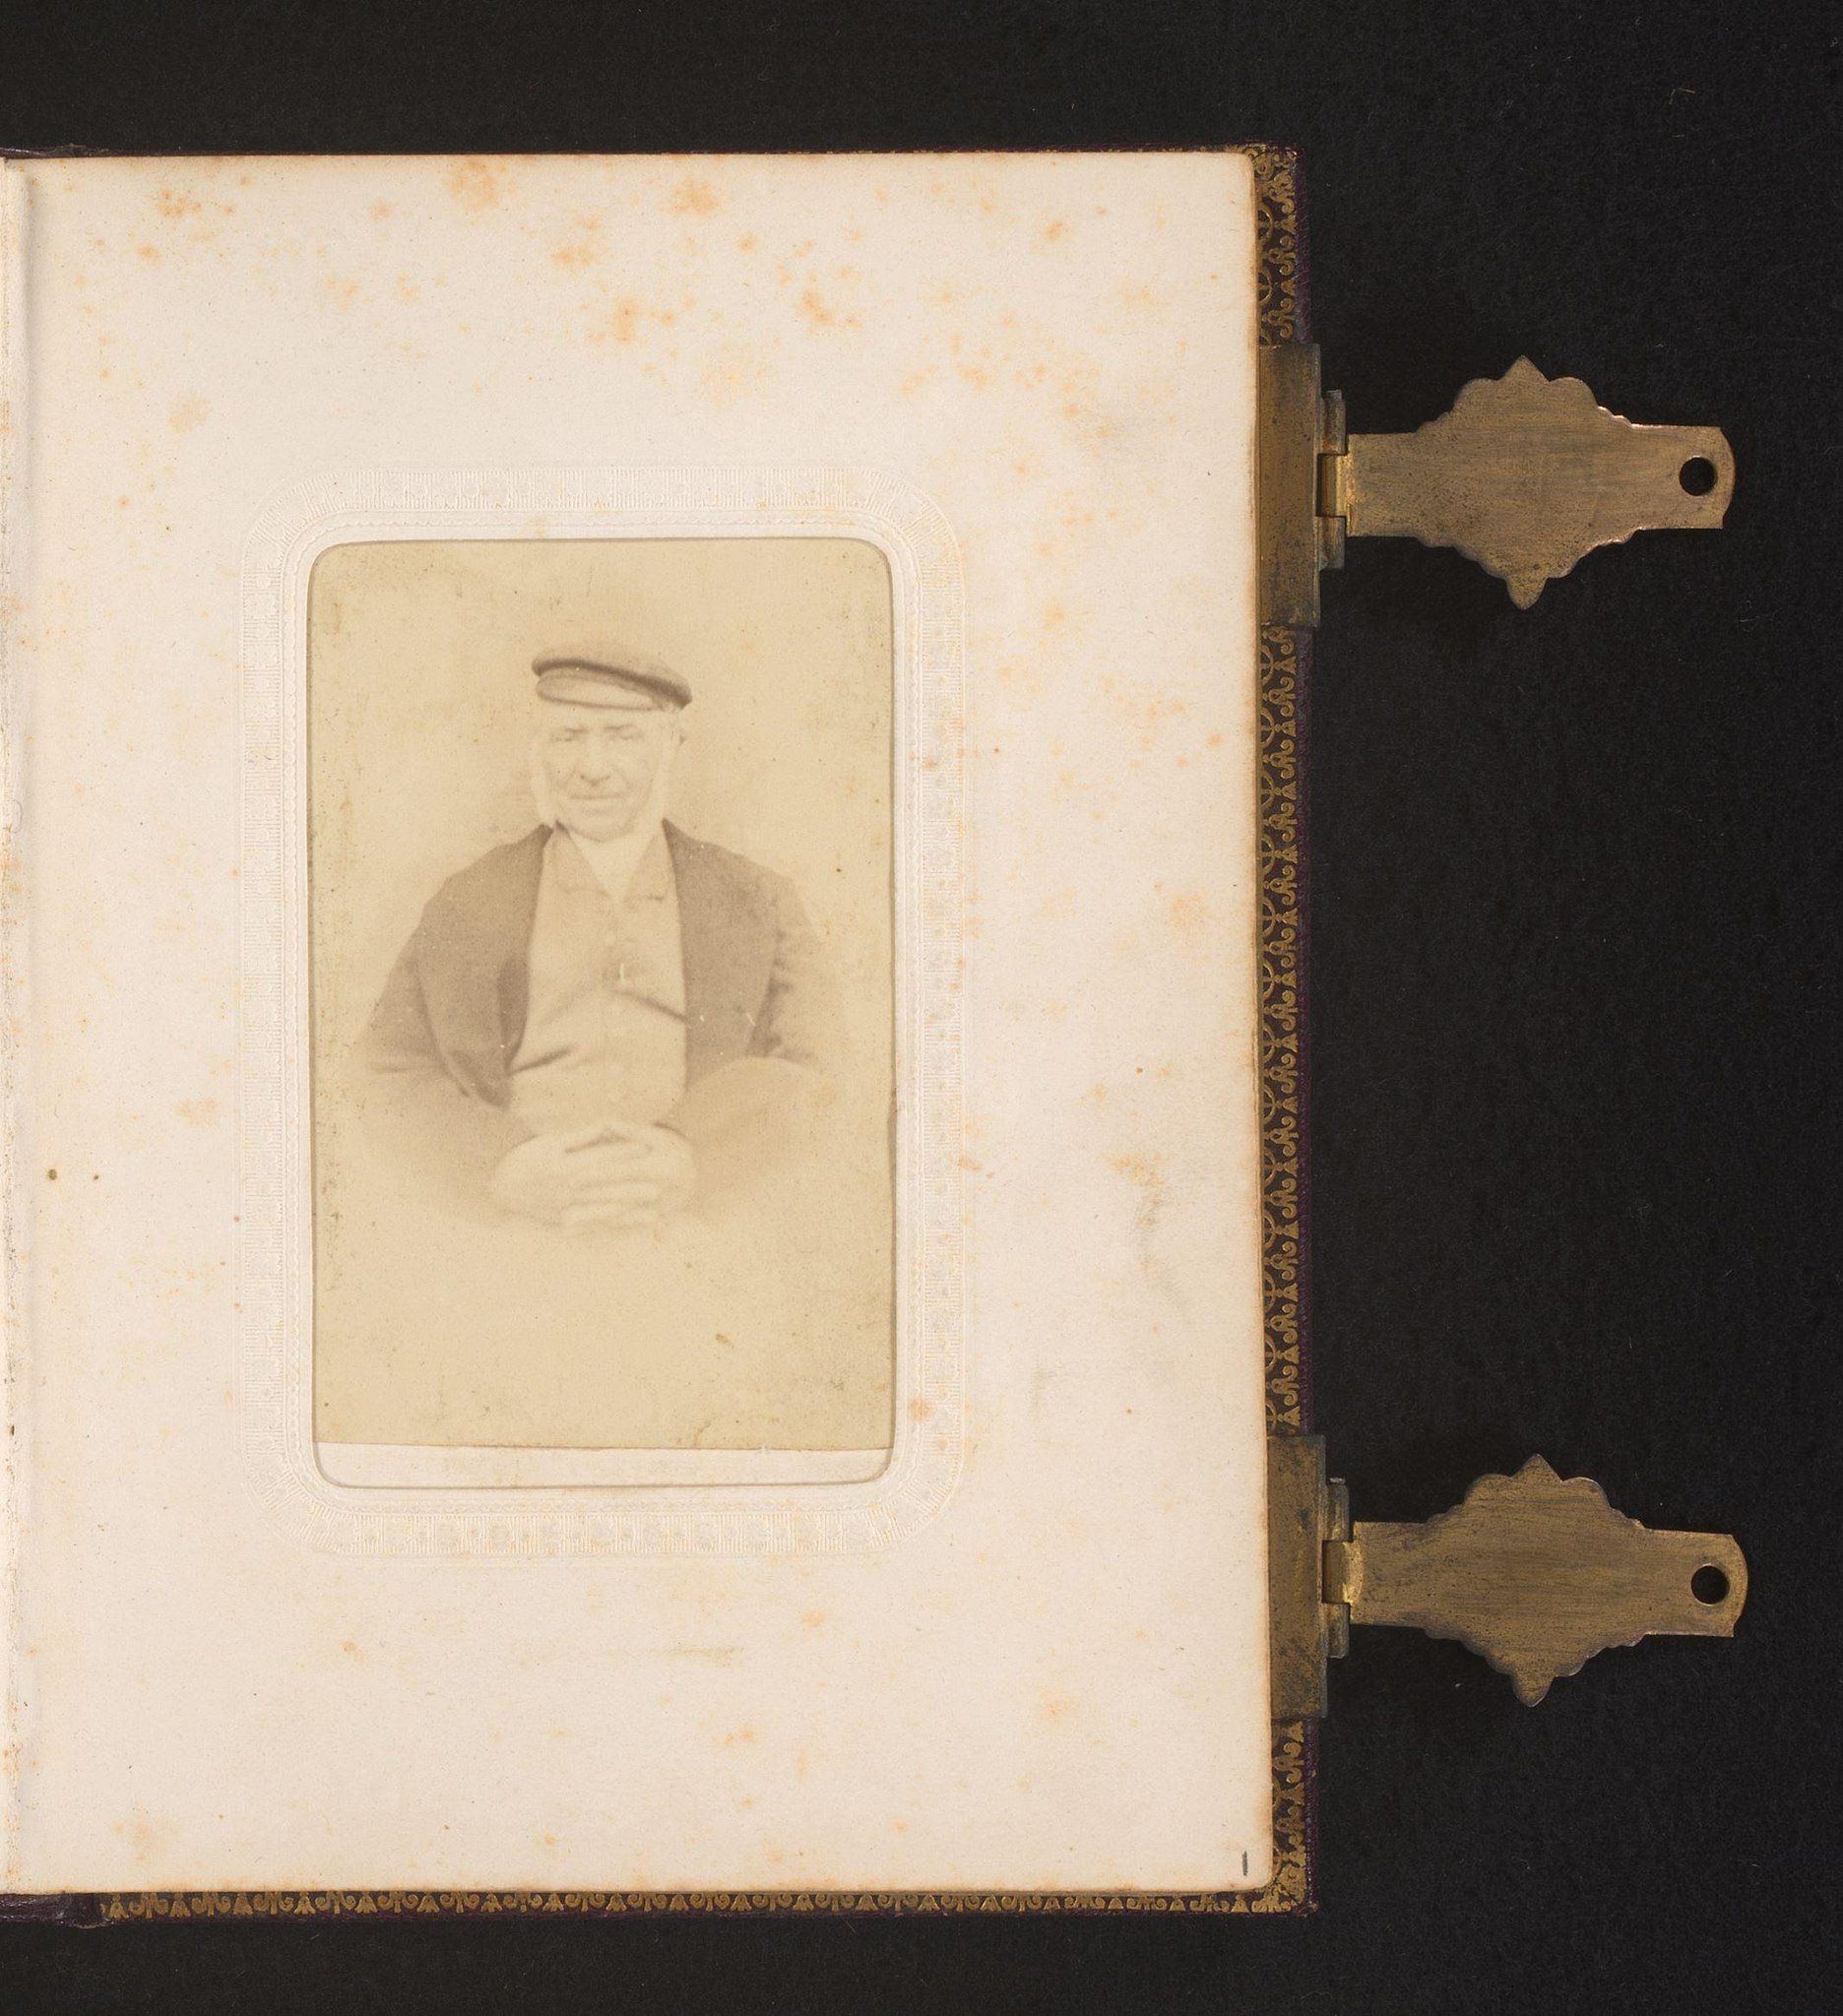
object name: album leaf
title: Portret van een man met pet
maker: Anonymous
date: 1860-1900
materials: cardboard, photographic support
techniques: albumen print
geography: france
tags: historical persons, head-gear: cap